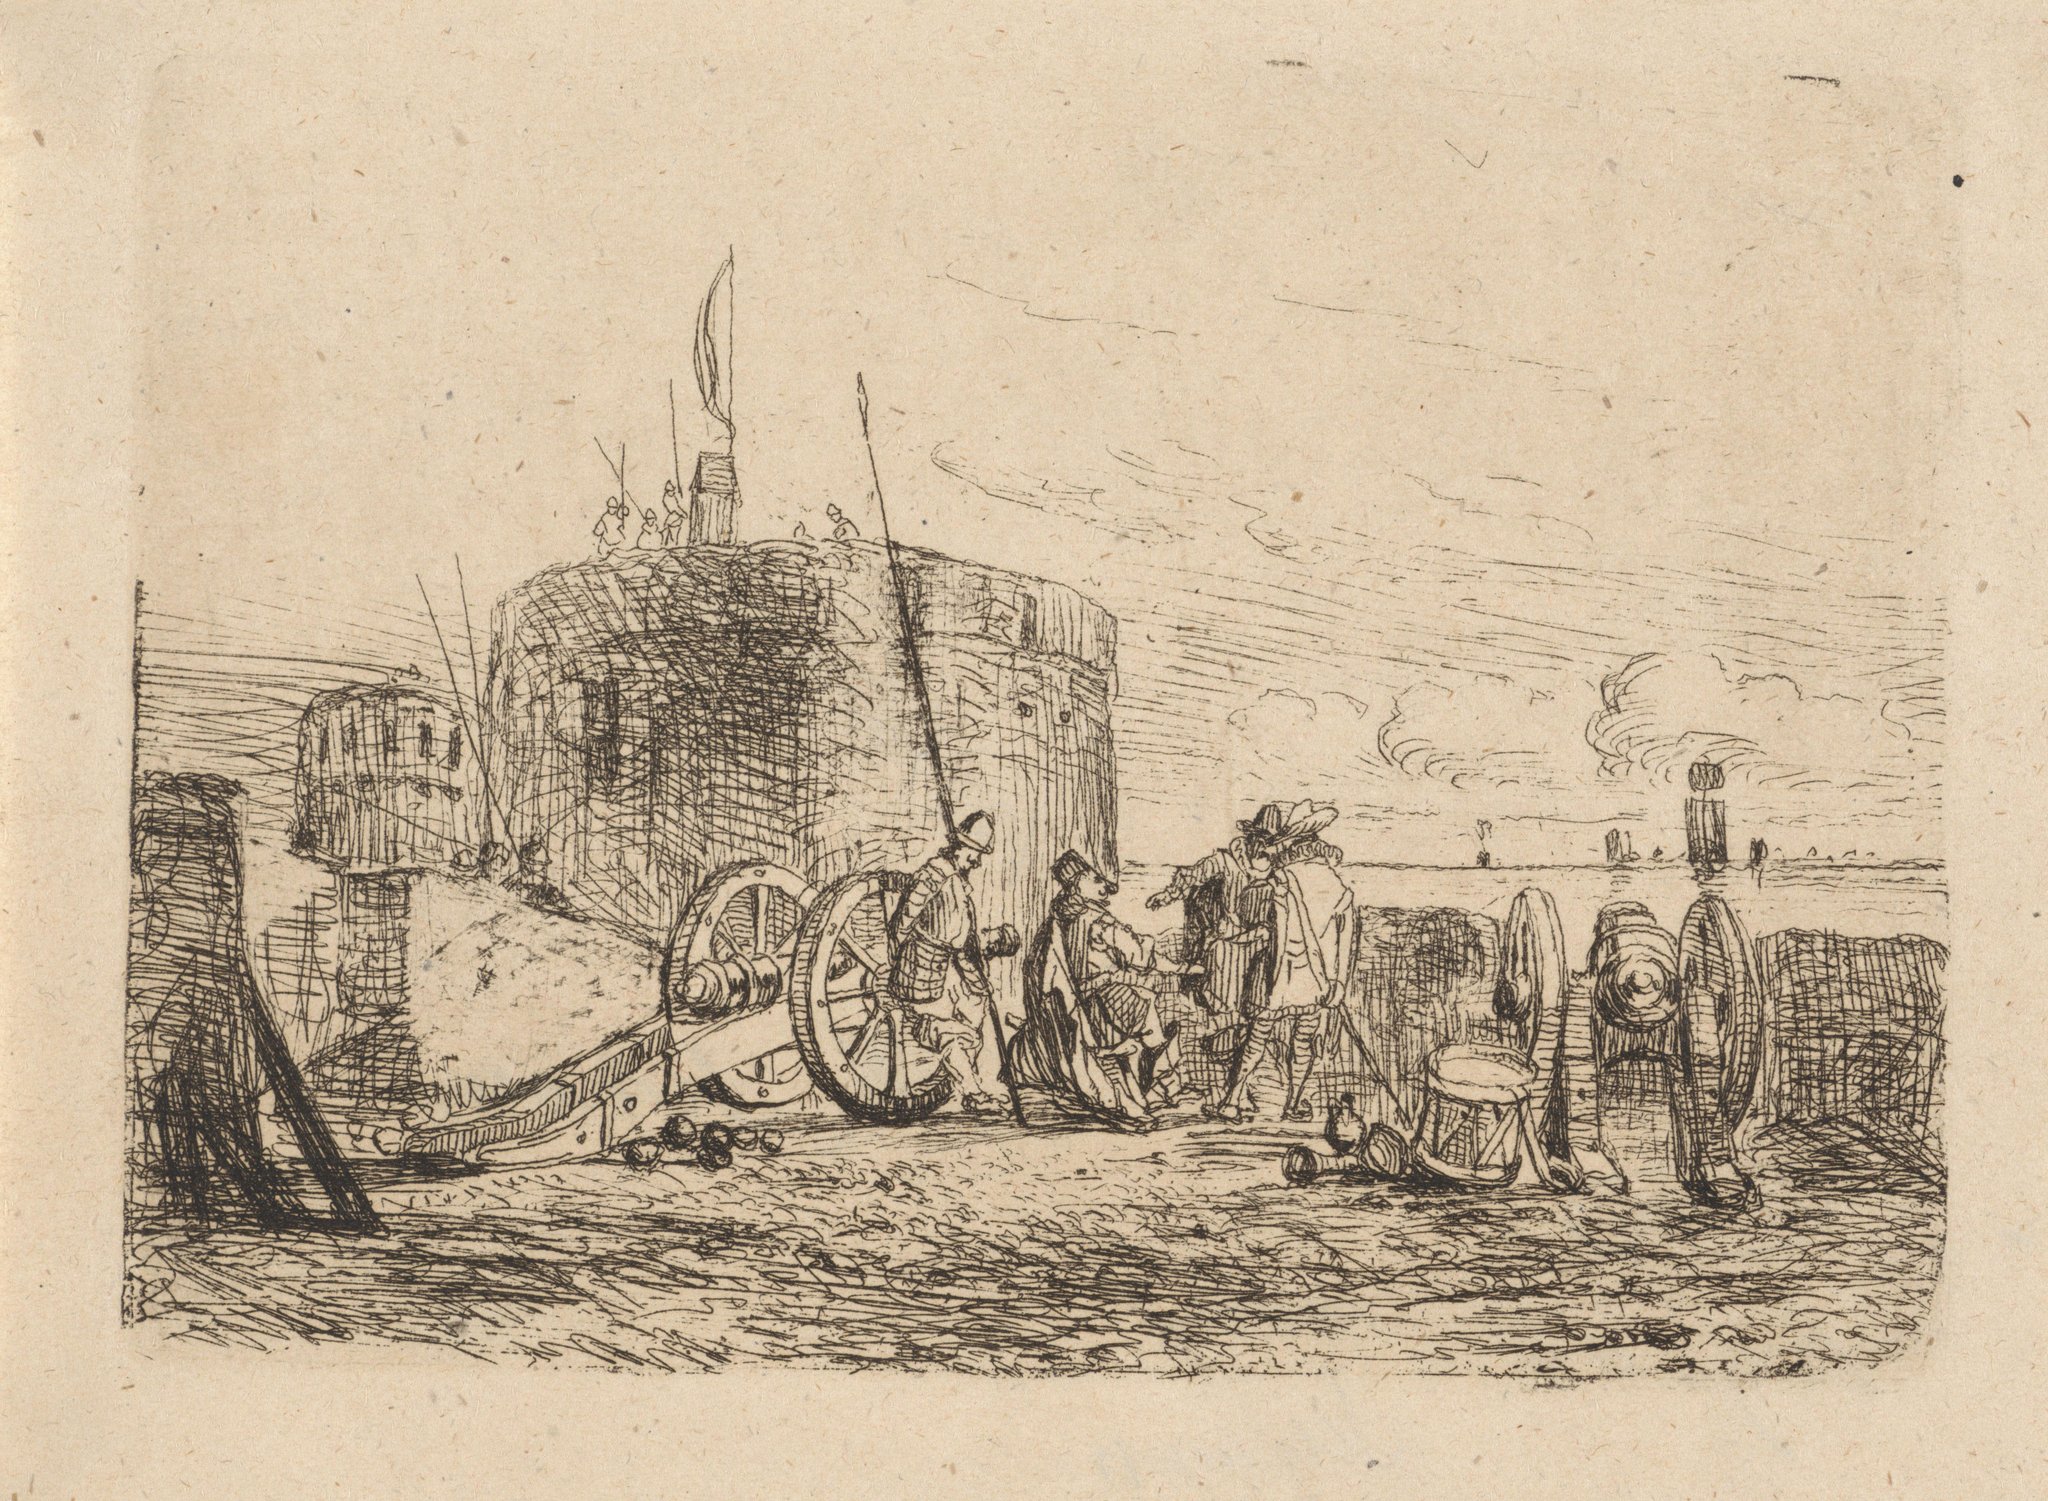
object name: print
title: Soldaten bij een kustbatterij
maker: henri adolphe schaep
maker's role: draughtsman, painter, print maker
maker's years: 1826-1870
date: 1841-1870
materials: paper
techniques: etching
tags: firearms: cannon, coast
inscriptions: collector's mark: Lugt 2228